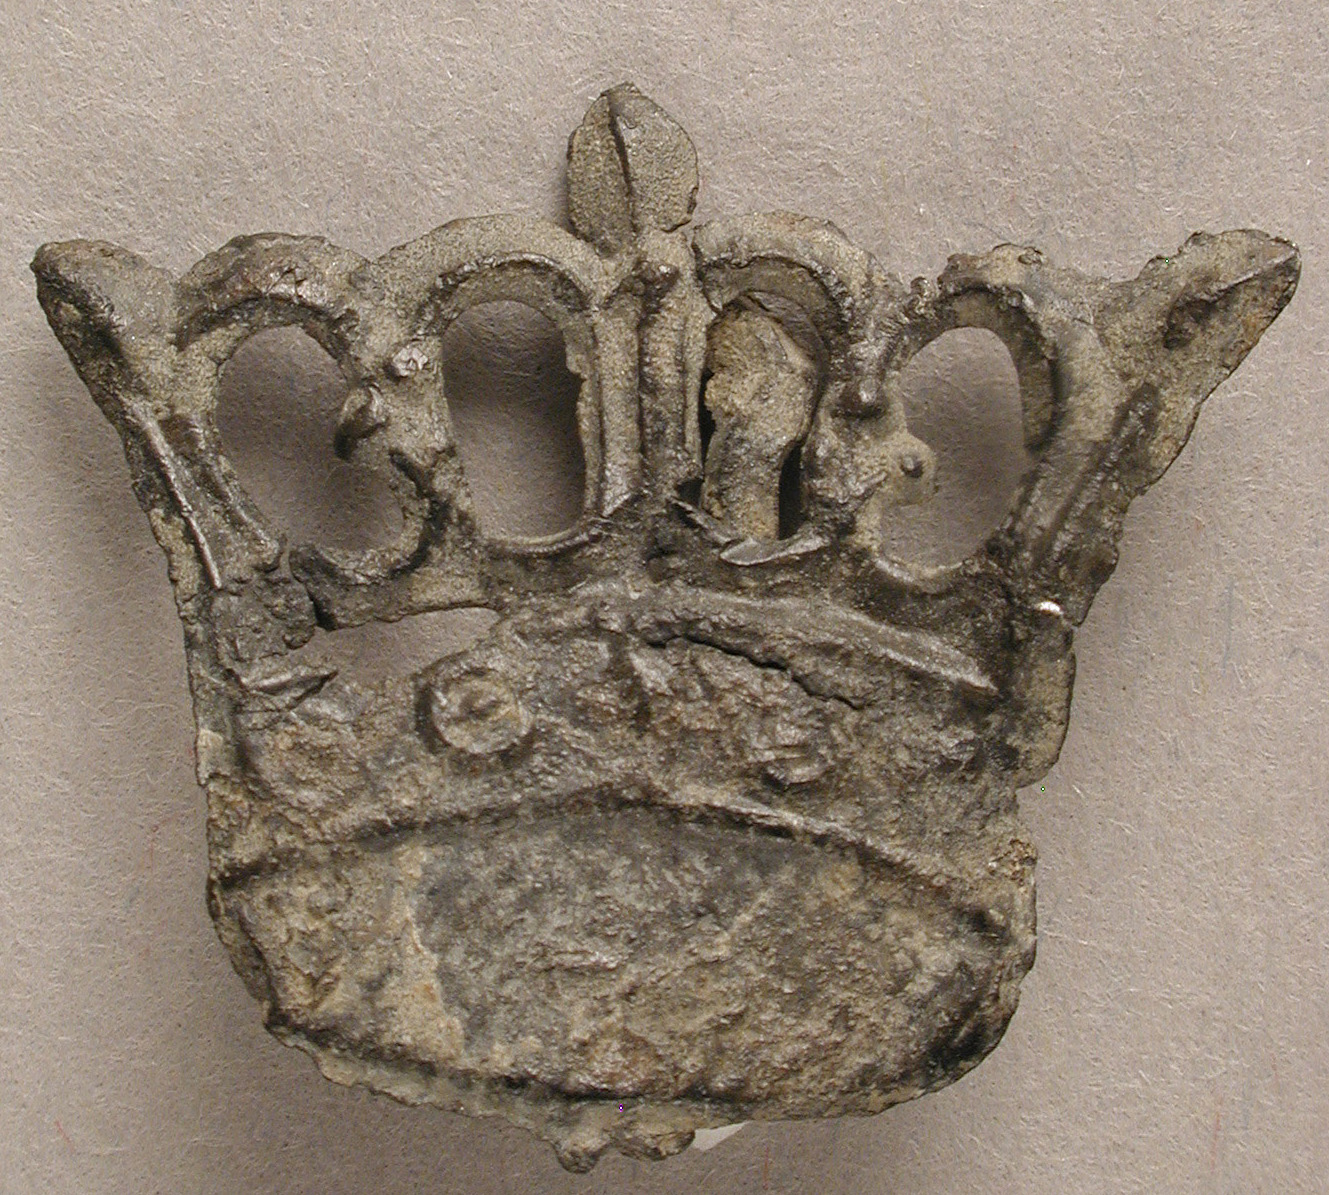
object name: pilgrim's badge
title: Badge with Shrine of Edward the Confessor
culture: british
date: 1401-1500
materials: alloy, lead, tin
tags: crowns